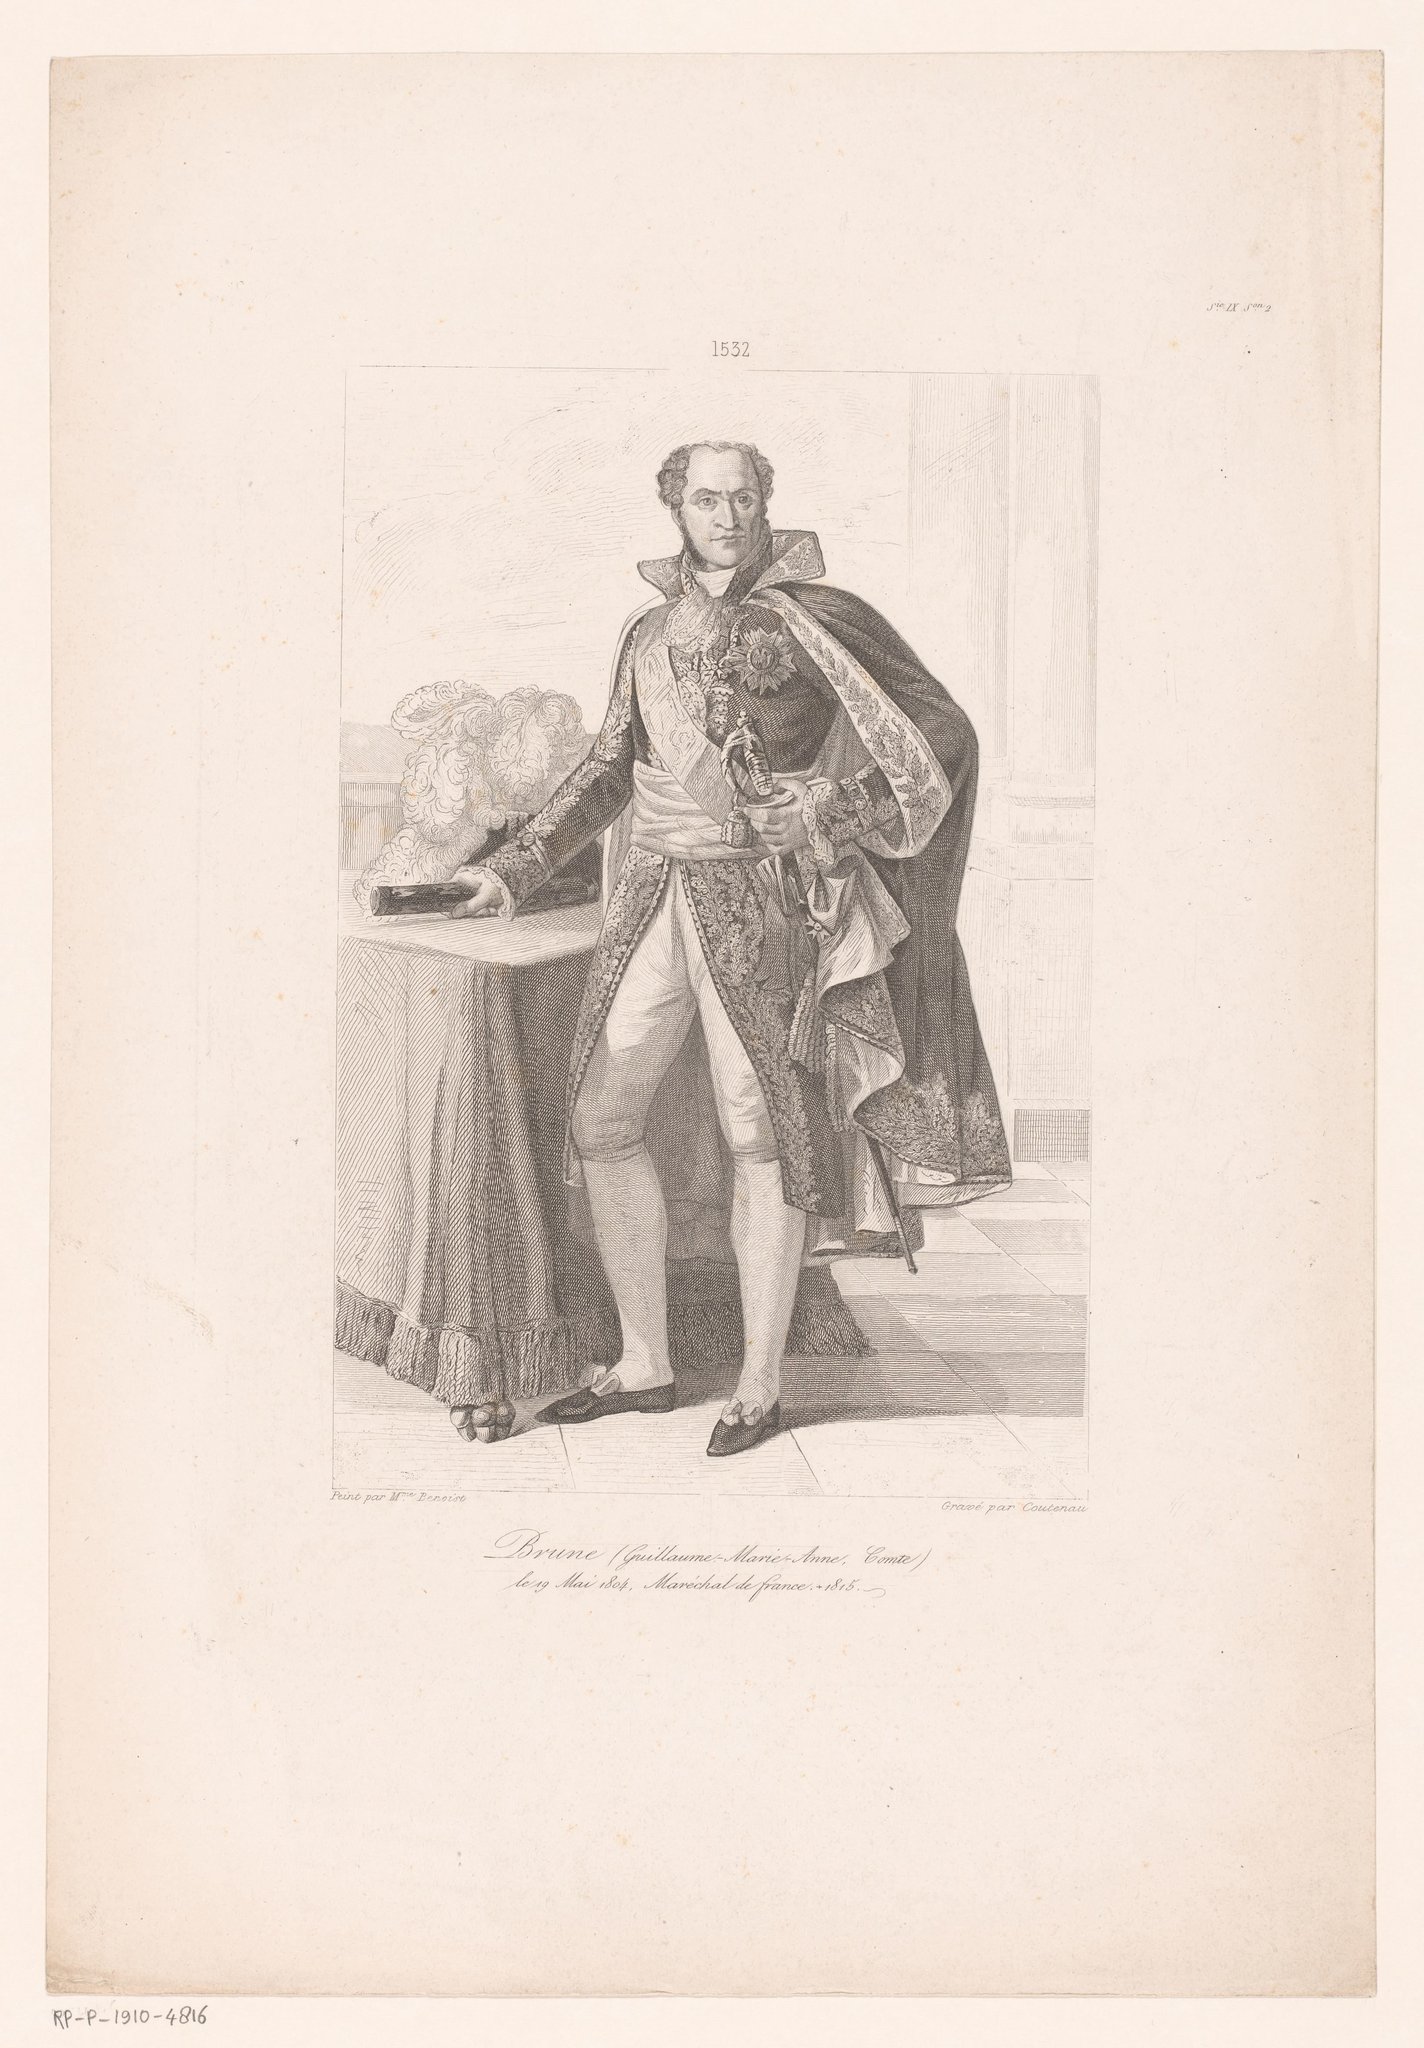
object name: book illustration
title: Brune (Guillaume-Marie-Anne, Comte) (...)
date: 1738-1841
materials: paper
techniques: engraving, etching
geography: paris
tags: historical persons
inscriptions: collector's mark: Lugt 2228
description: Prent uit: s.n. Galeries historiques de Versailles. Parijs: Charles Gavard, 1838-1841.